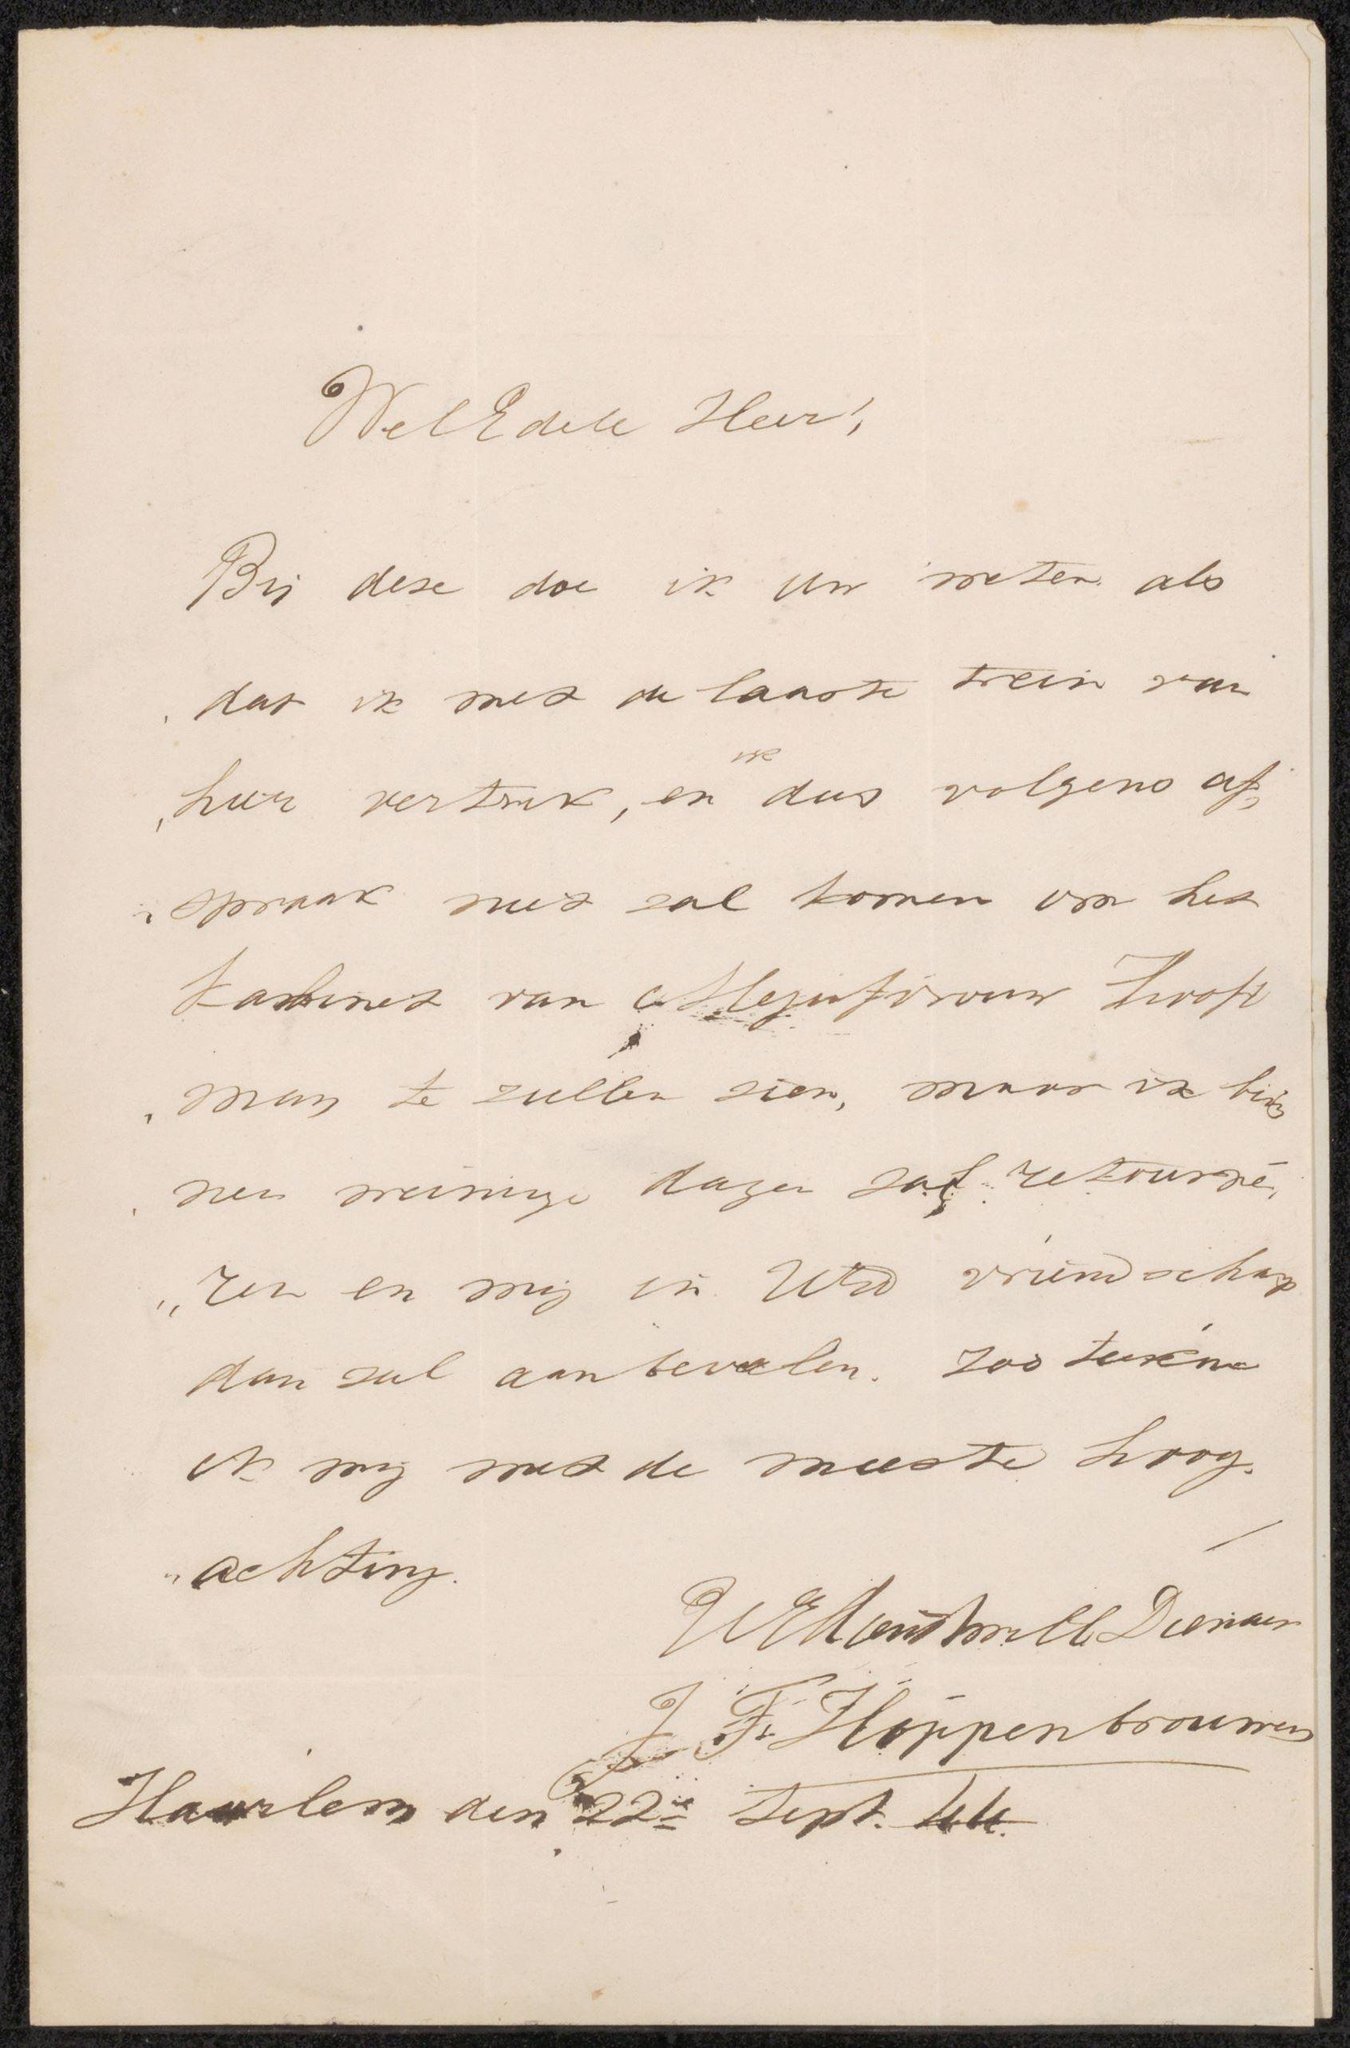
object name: letter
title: Brief aan Adriaan van der Willigen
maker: johannes franciscus hoppenbrouwers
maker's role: draughtsman, painter, print maker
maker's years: 1819-1866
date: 1844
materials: ink, paper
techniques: pen, writing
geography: haarlem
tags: rotterdam, adriaan van der willigen